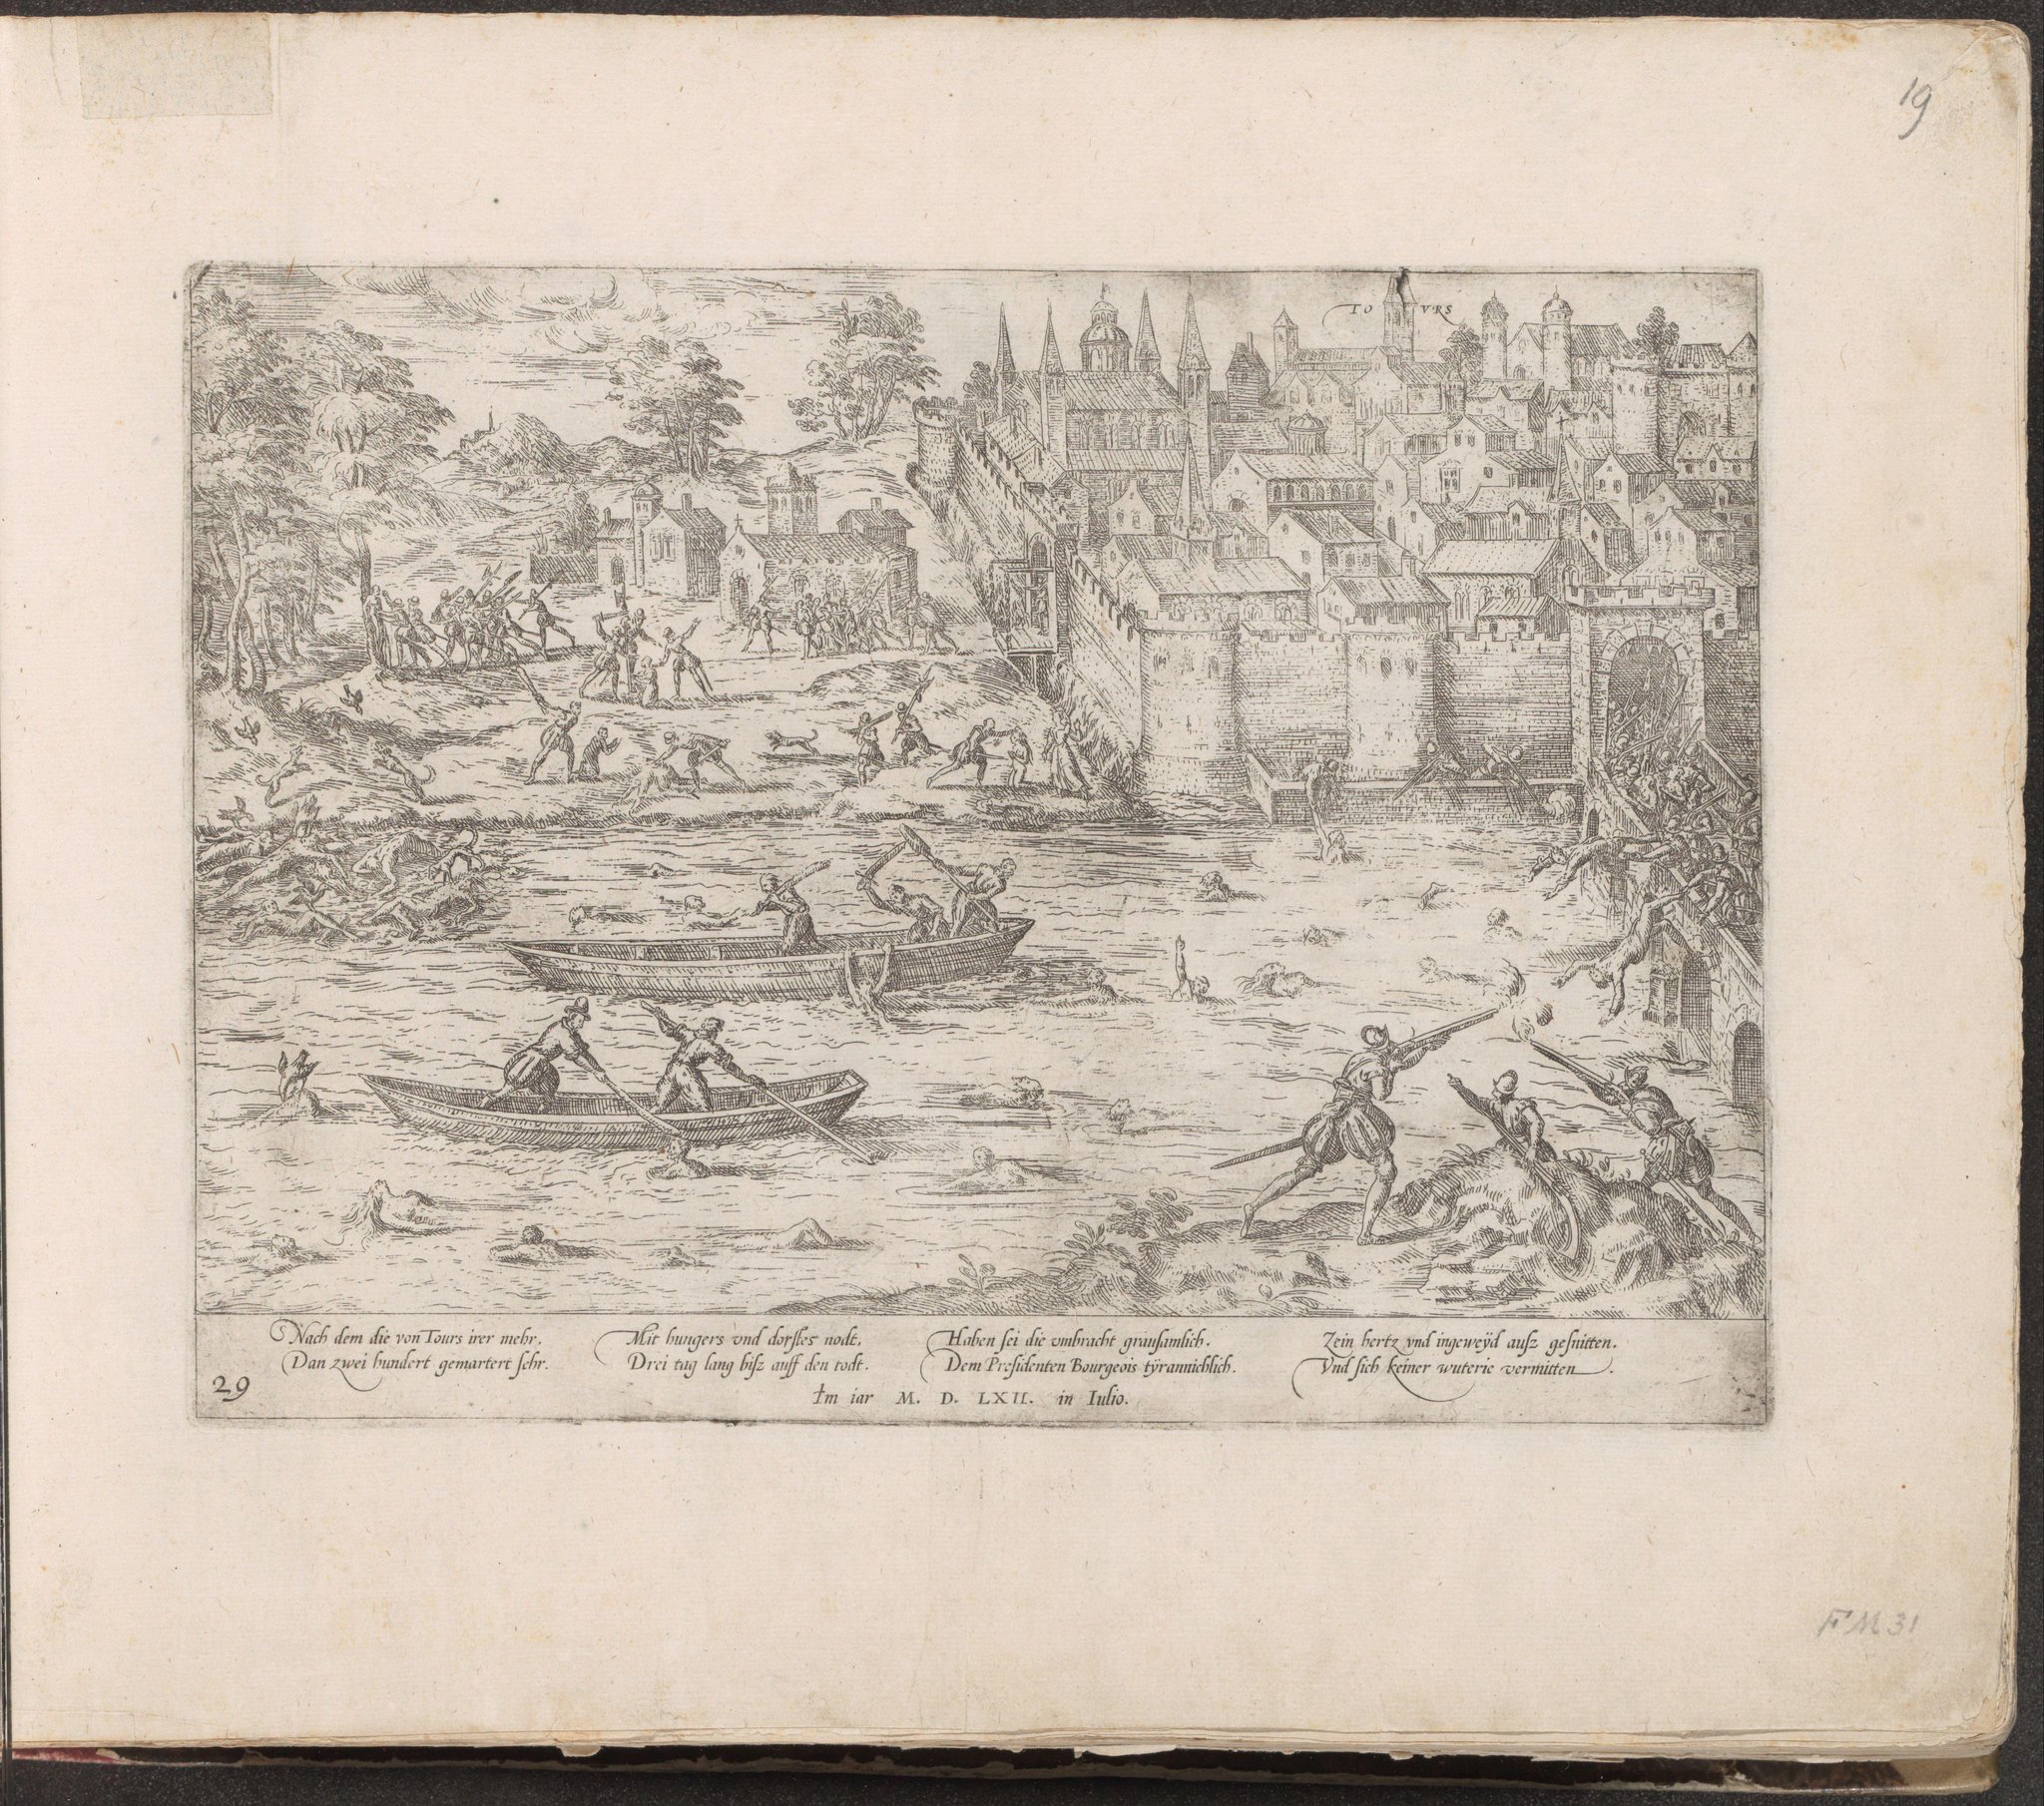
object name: print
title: Moord op de protestanten in Tours, 1562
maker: frans hogenberg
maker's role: print maker, publisher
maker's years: 1538-1590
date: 1567-1571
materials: paper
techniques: etching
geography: cologne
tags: massacre ~ war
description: Moord op de protestanten in Tours, juli 1562. Slachting door soldaten buiten de muren van stad, op de brug en in het water. Met onderschrift van 8 regels in het Duits. Linksonder genummerd: 29. De prent maakt deel uit van een album.